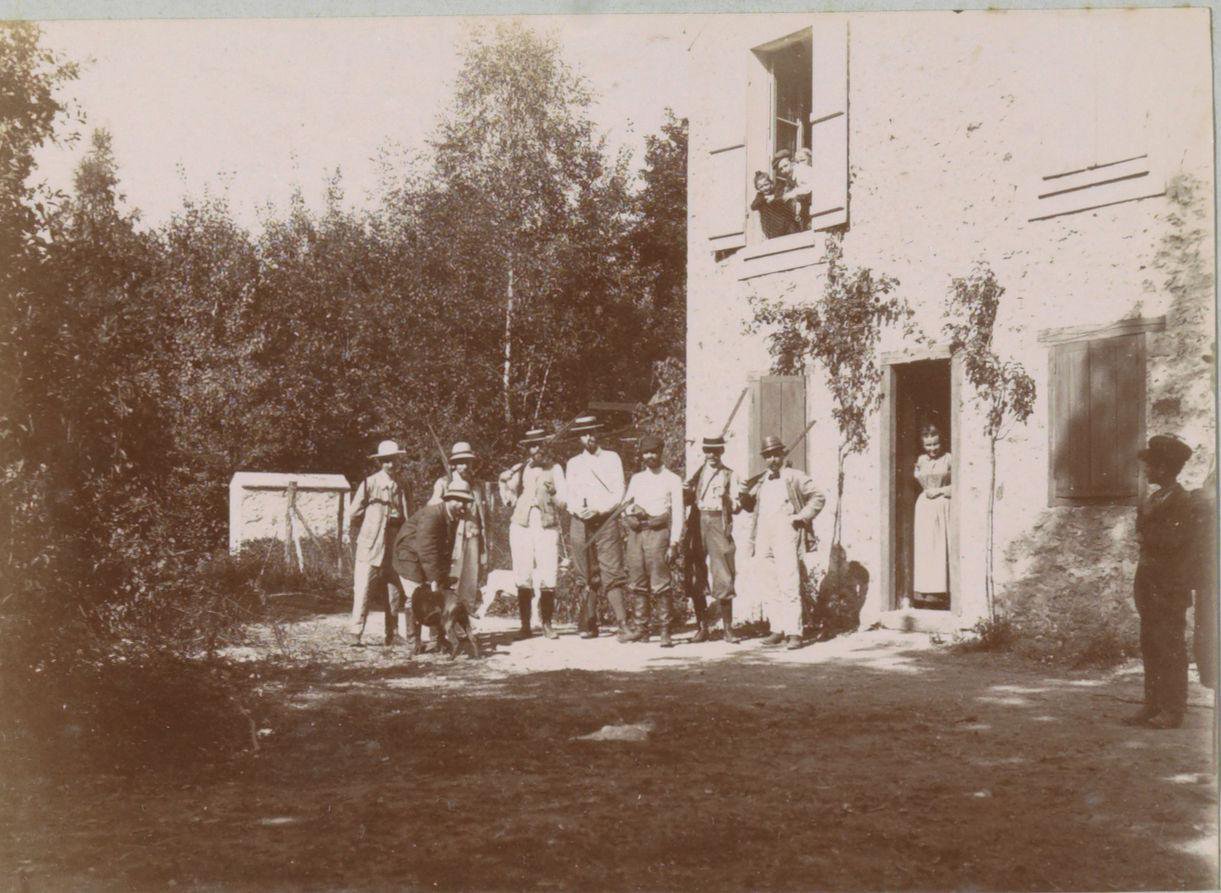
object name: photograph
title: Jachtgezelschap, vermoedelijk in Midden-Frankrijk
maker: delizy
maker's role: manufacturer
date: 1899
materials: paper, photographic support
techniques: gelatin silver print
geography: france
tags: hunter, france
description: Onderdeel van Fotoalbum van een Franse amateurfotograaf met opnames van uitstapjes in Frankrijk, Spanje, België, Luxemburg en Nederland, de eerste automobielen en autoraces.